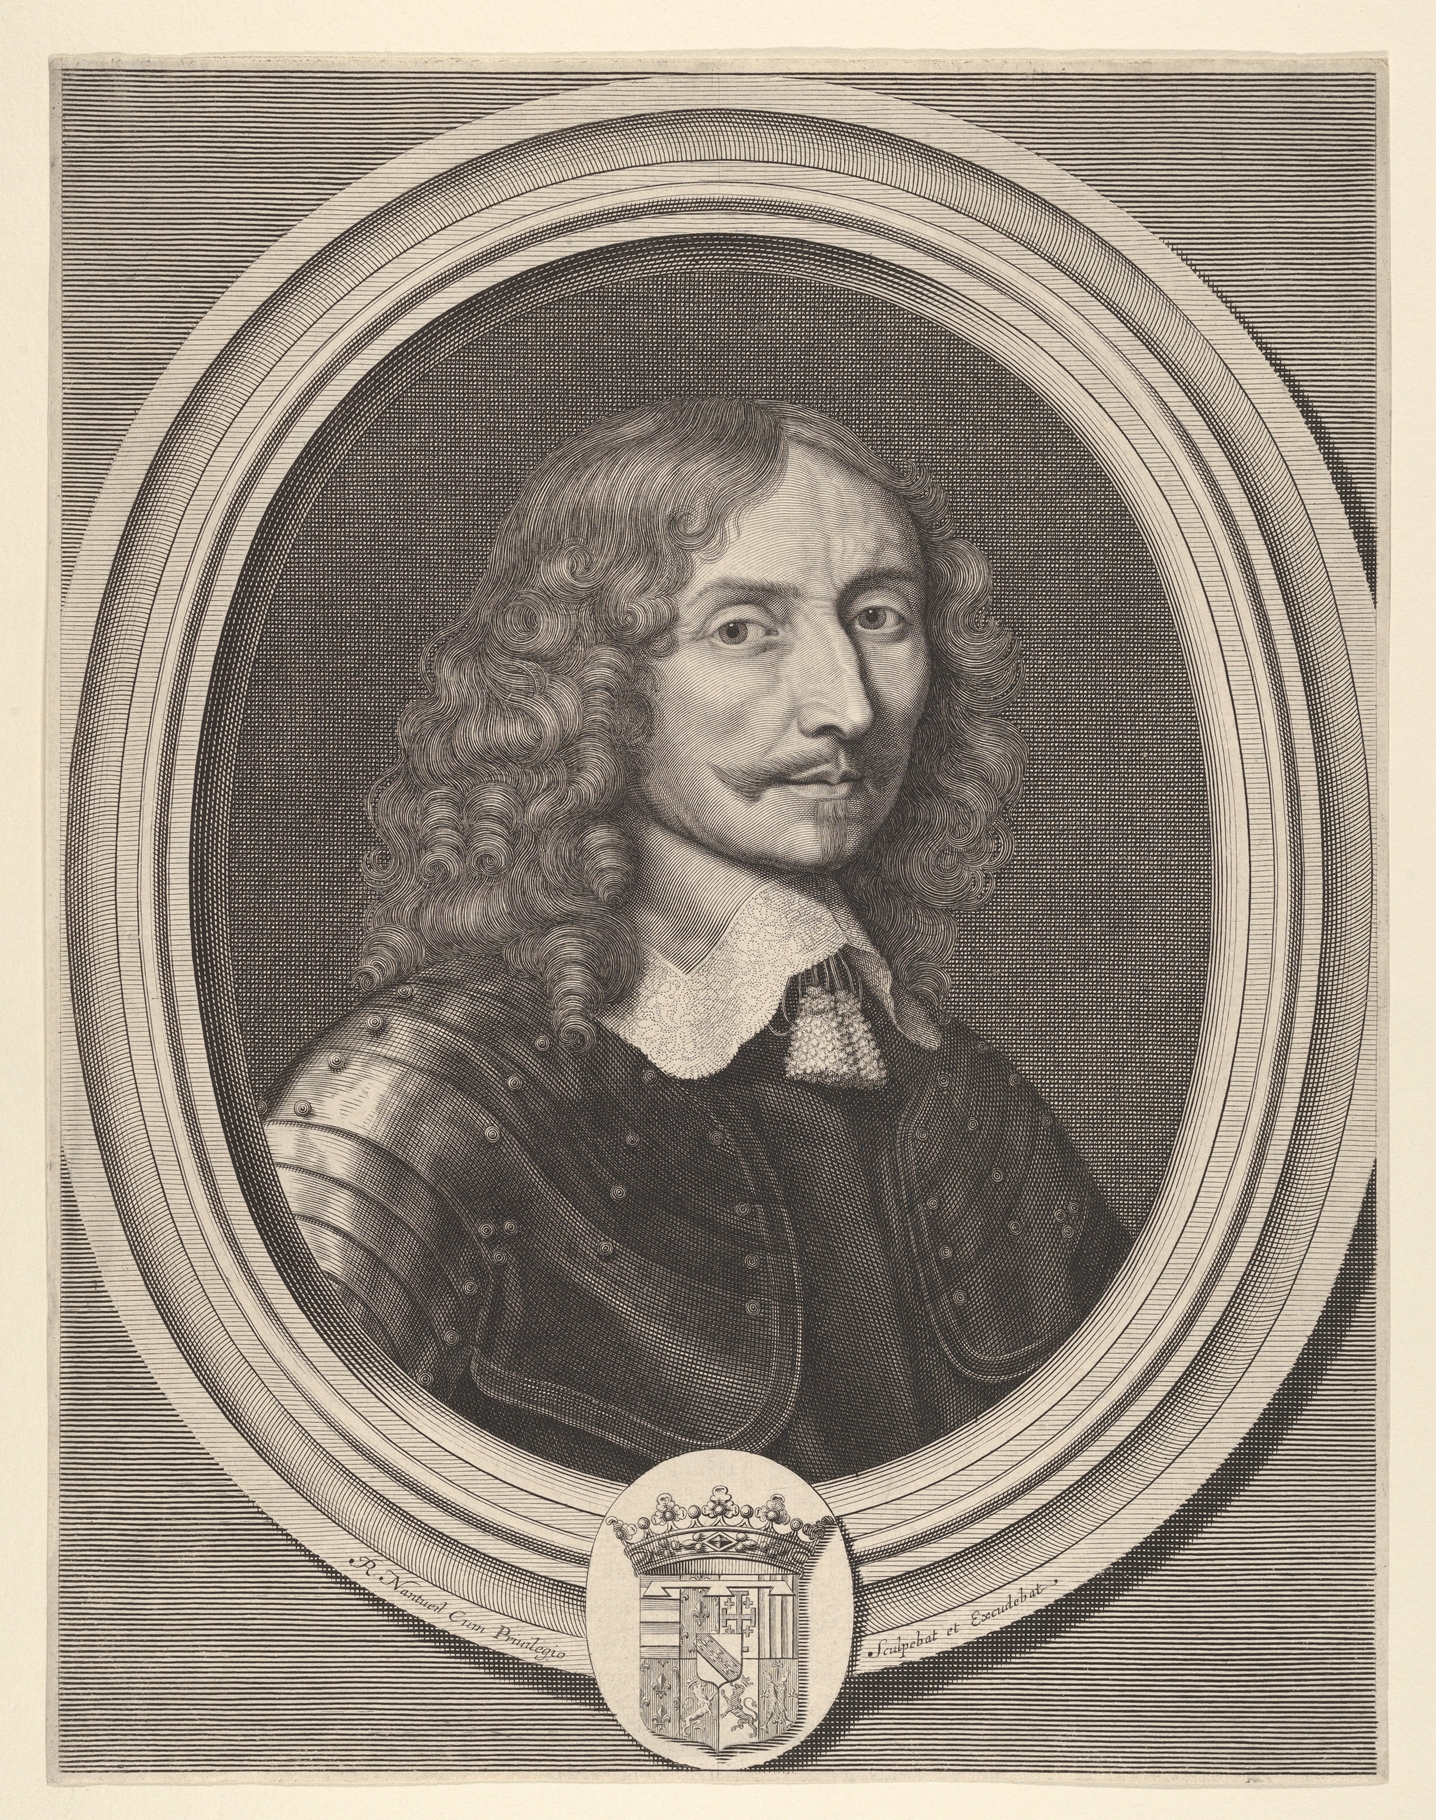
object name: print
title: Henri II de Lorraine, marquis de Mouy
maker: robert nanteuil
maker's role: artist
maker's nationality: french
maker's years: 1623-1678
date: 1651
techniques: engraving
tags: men,portraits